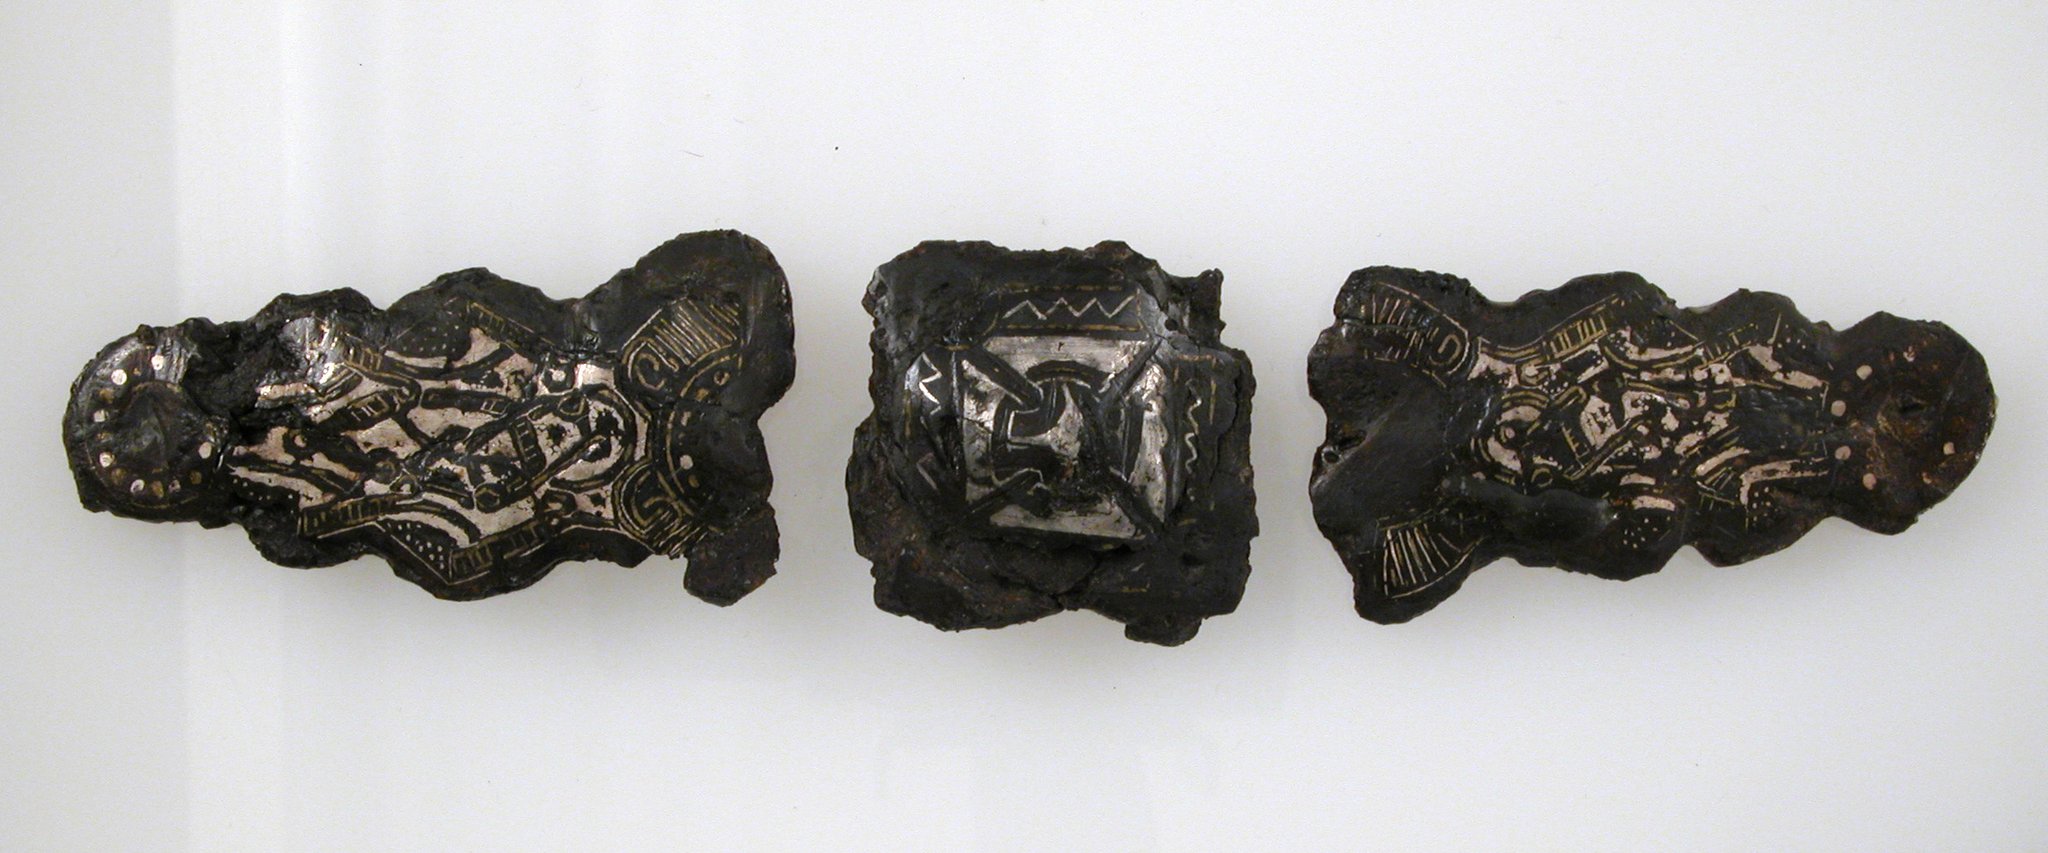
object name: belt plate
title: Belt Plates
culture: frankish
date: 667-700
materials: brass, iron, silver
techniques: inlay